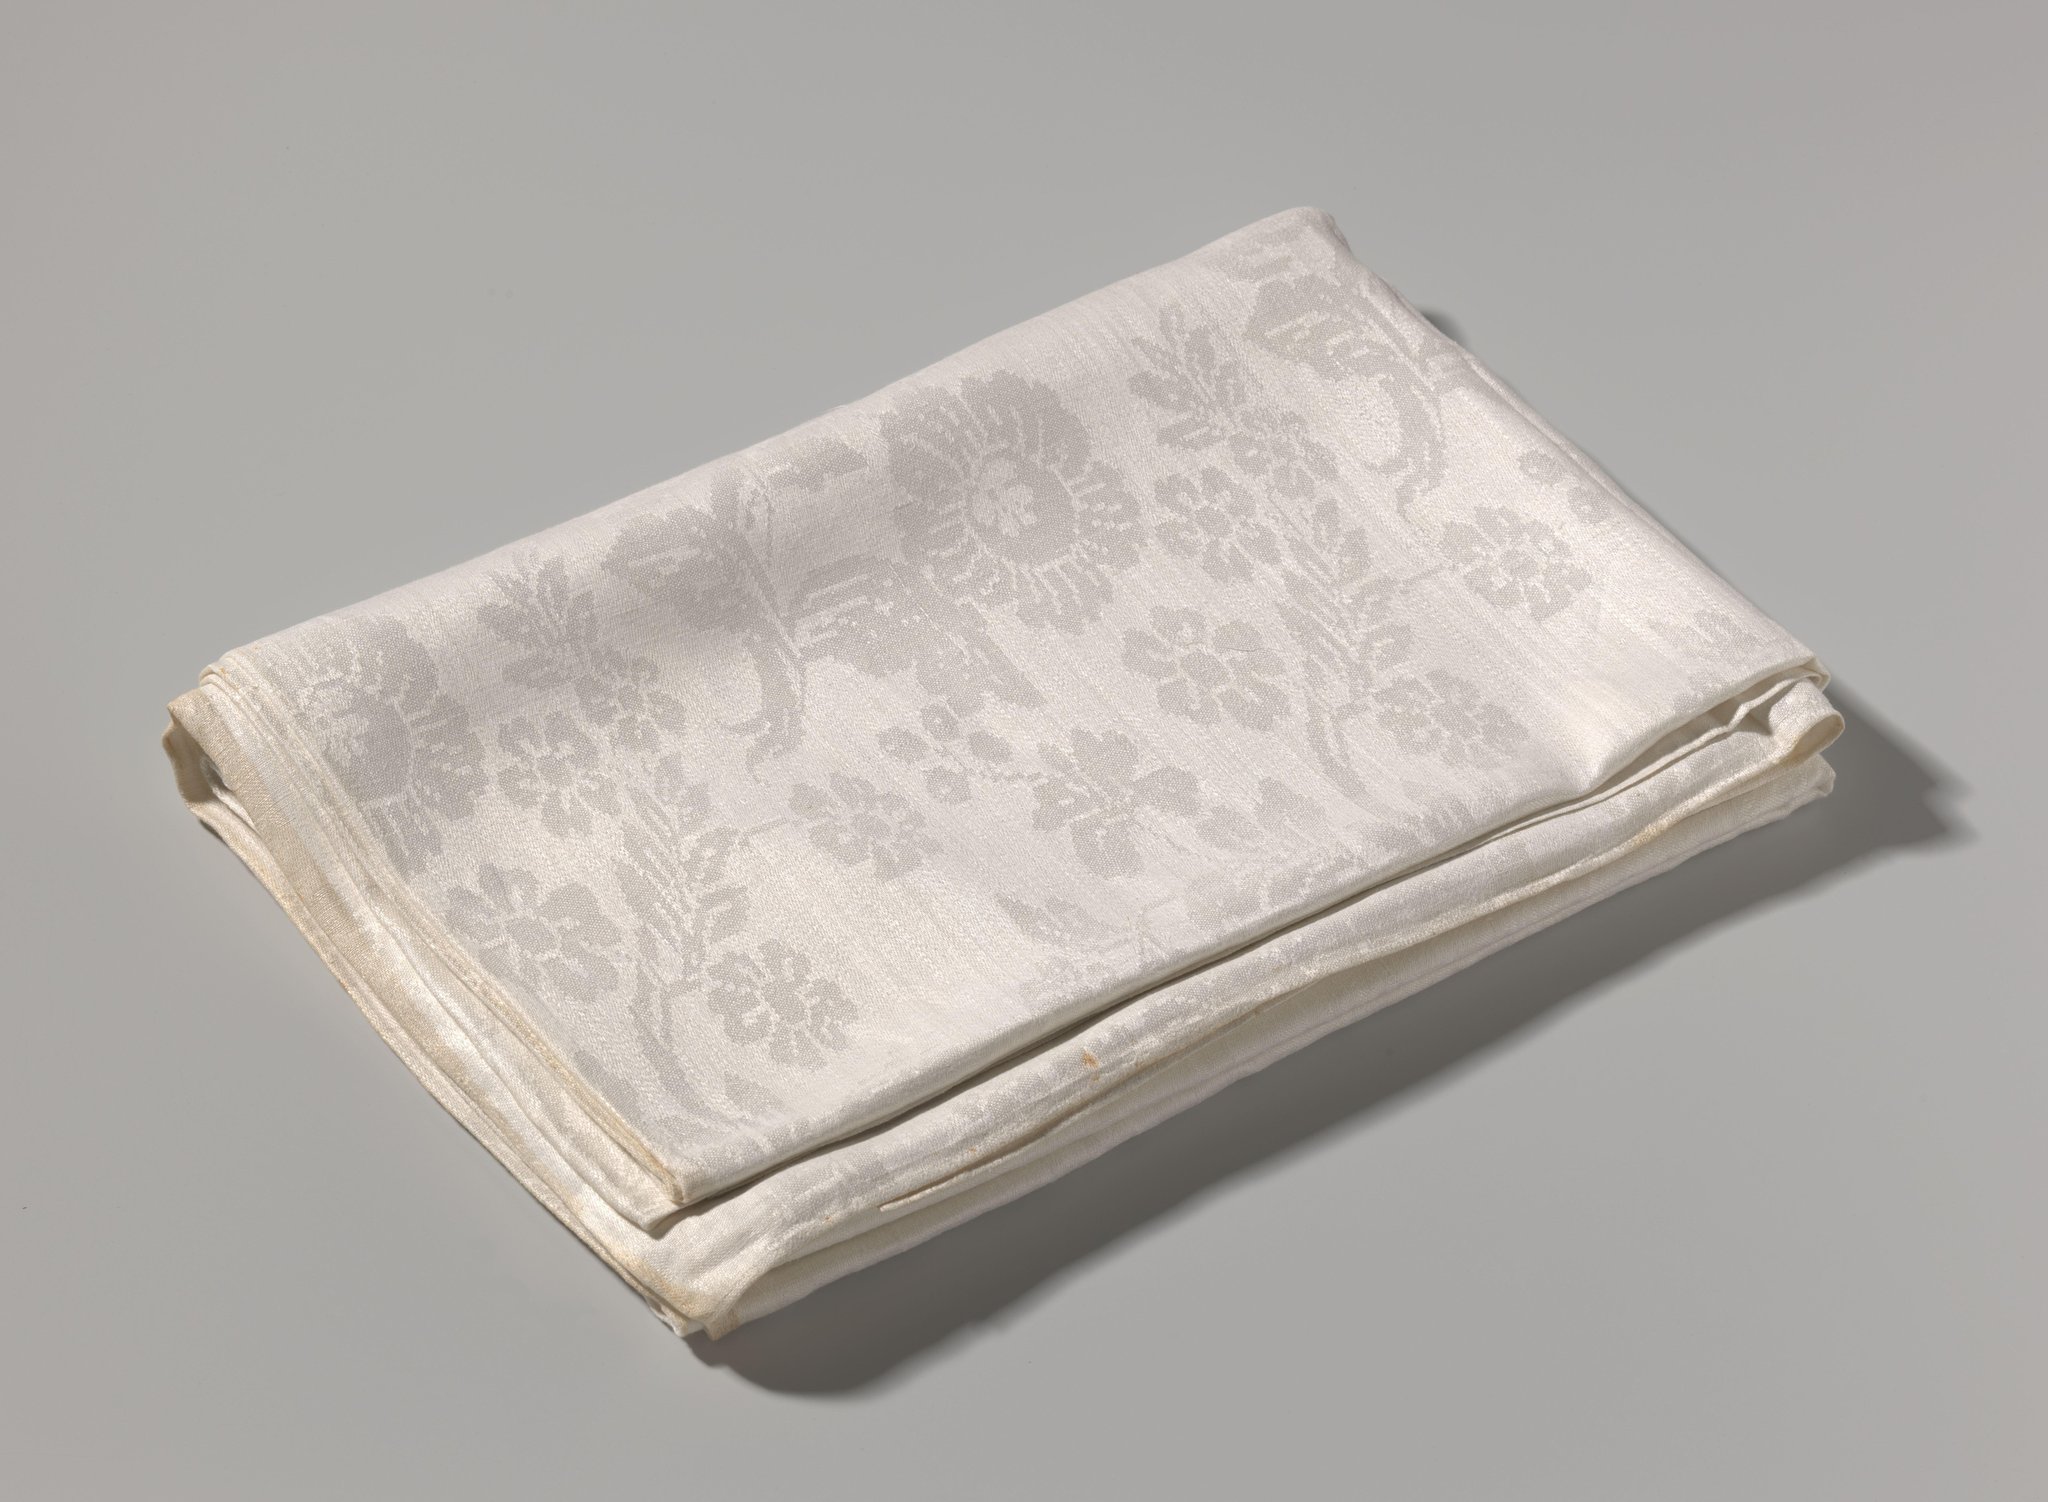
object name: tablecloth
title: Tafellaken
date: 1740-1760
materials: linen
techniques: damask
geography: germany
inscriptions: mark: ‘K’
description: Tafellaken van witlinnen damast, versierd met bloemtakken. Stukgoed met lopende randen en tussenrand; twee banen aaneengenaaid in de lengte. Gemerkt K.